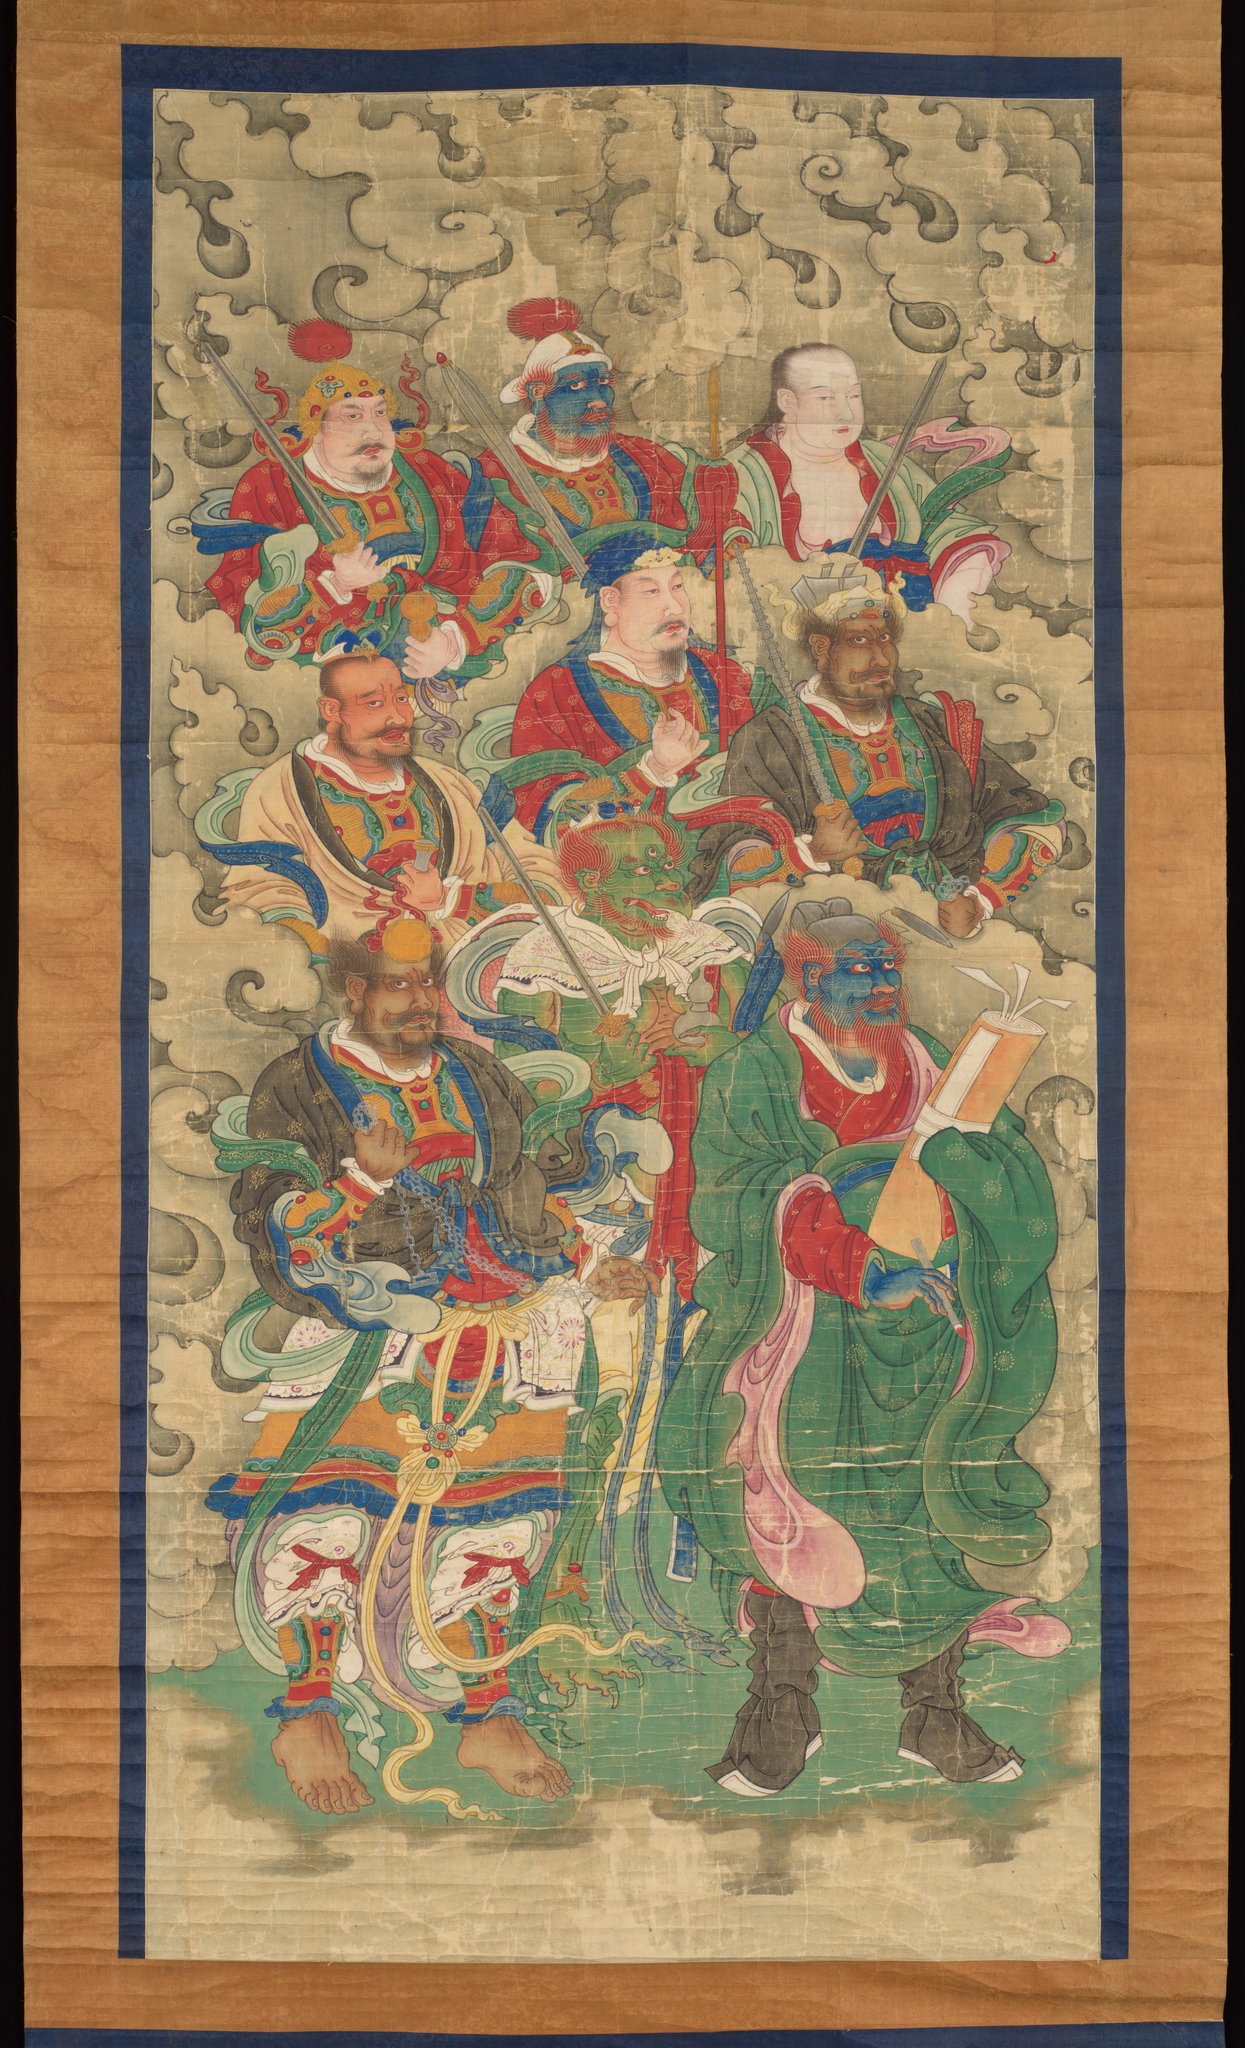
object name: hanging scroll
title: Nine Guardian Kings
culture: chinese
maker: unidentified artist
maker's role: artist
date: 1368-1644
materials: ink, paper